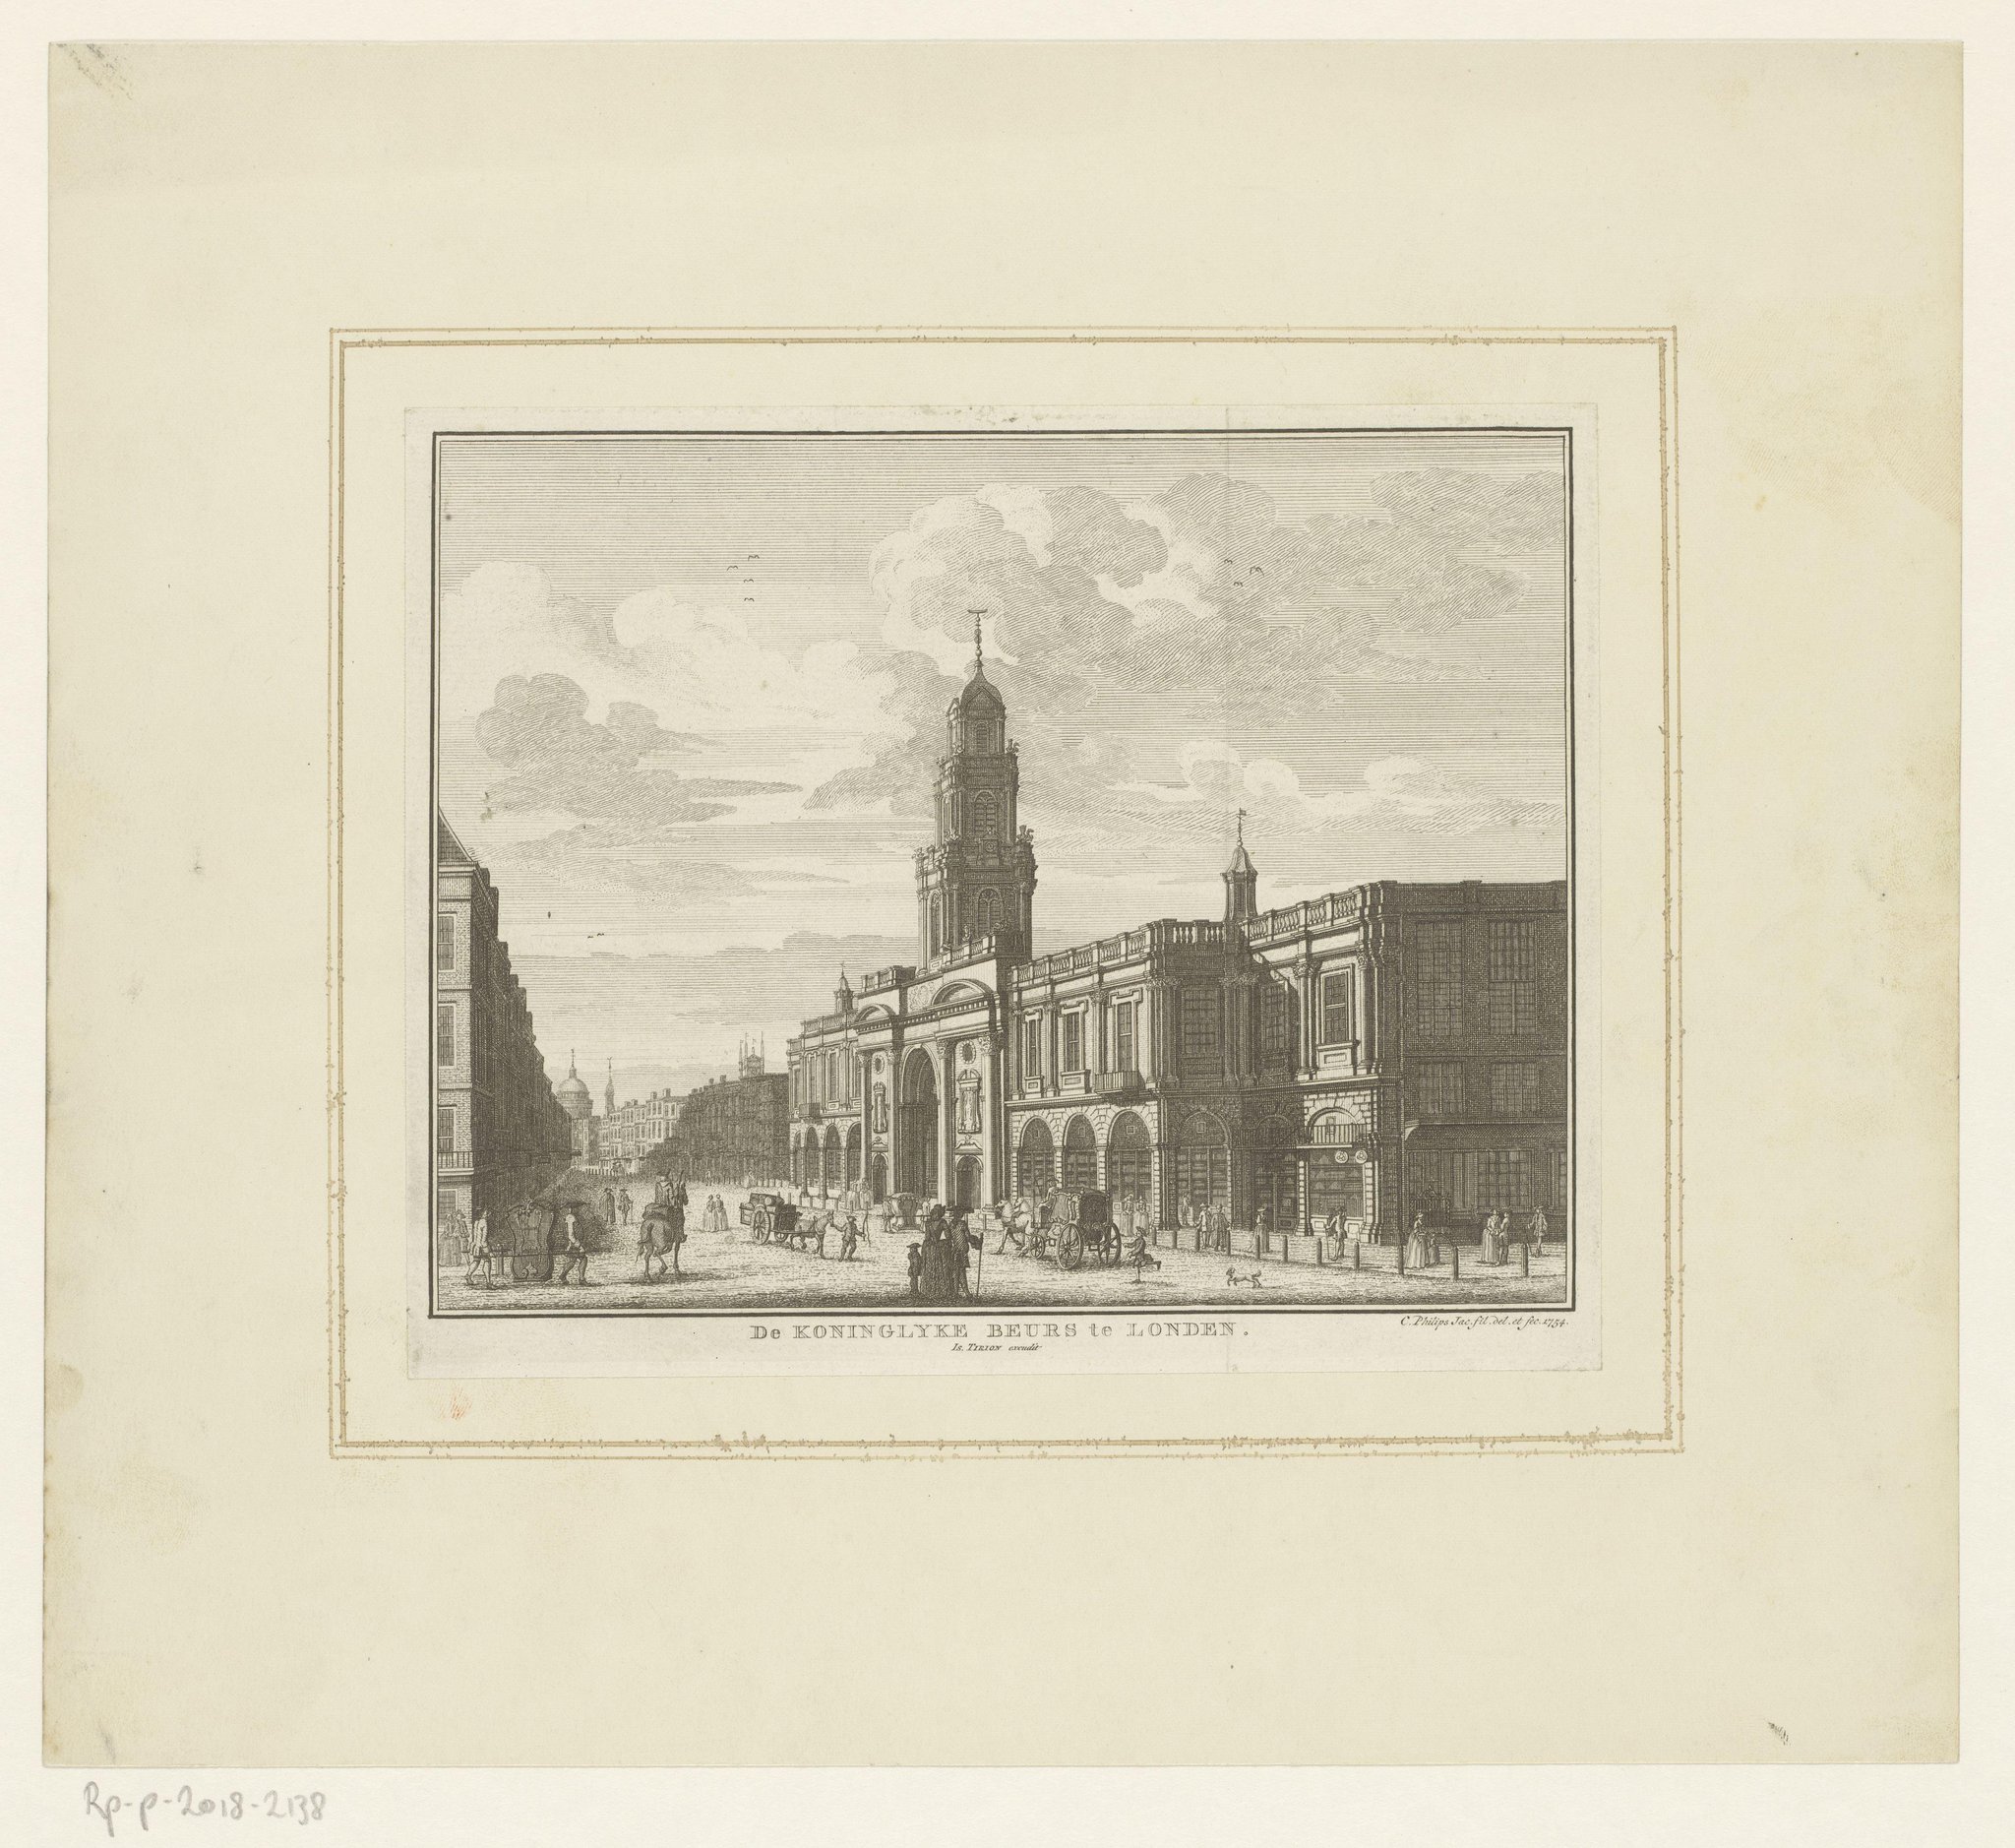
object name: print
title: De Koninglyke Beurs te Londen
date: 1754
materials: paper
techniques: etching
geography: amsterdam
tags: exchange, bourse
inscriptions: collector's mark: Lugt 2228